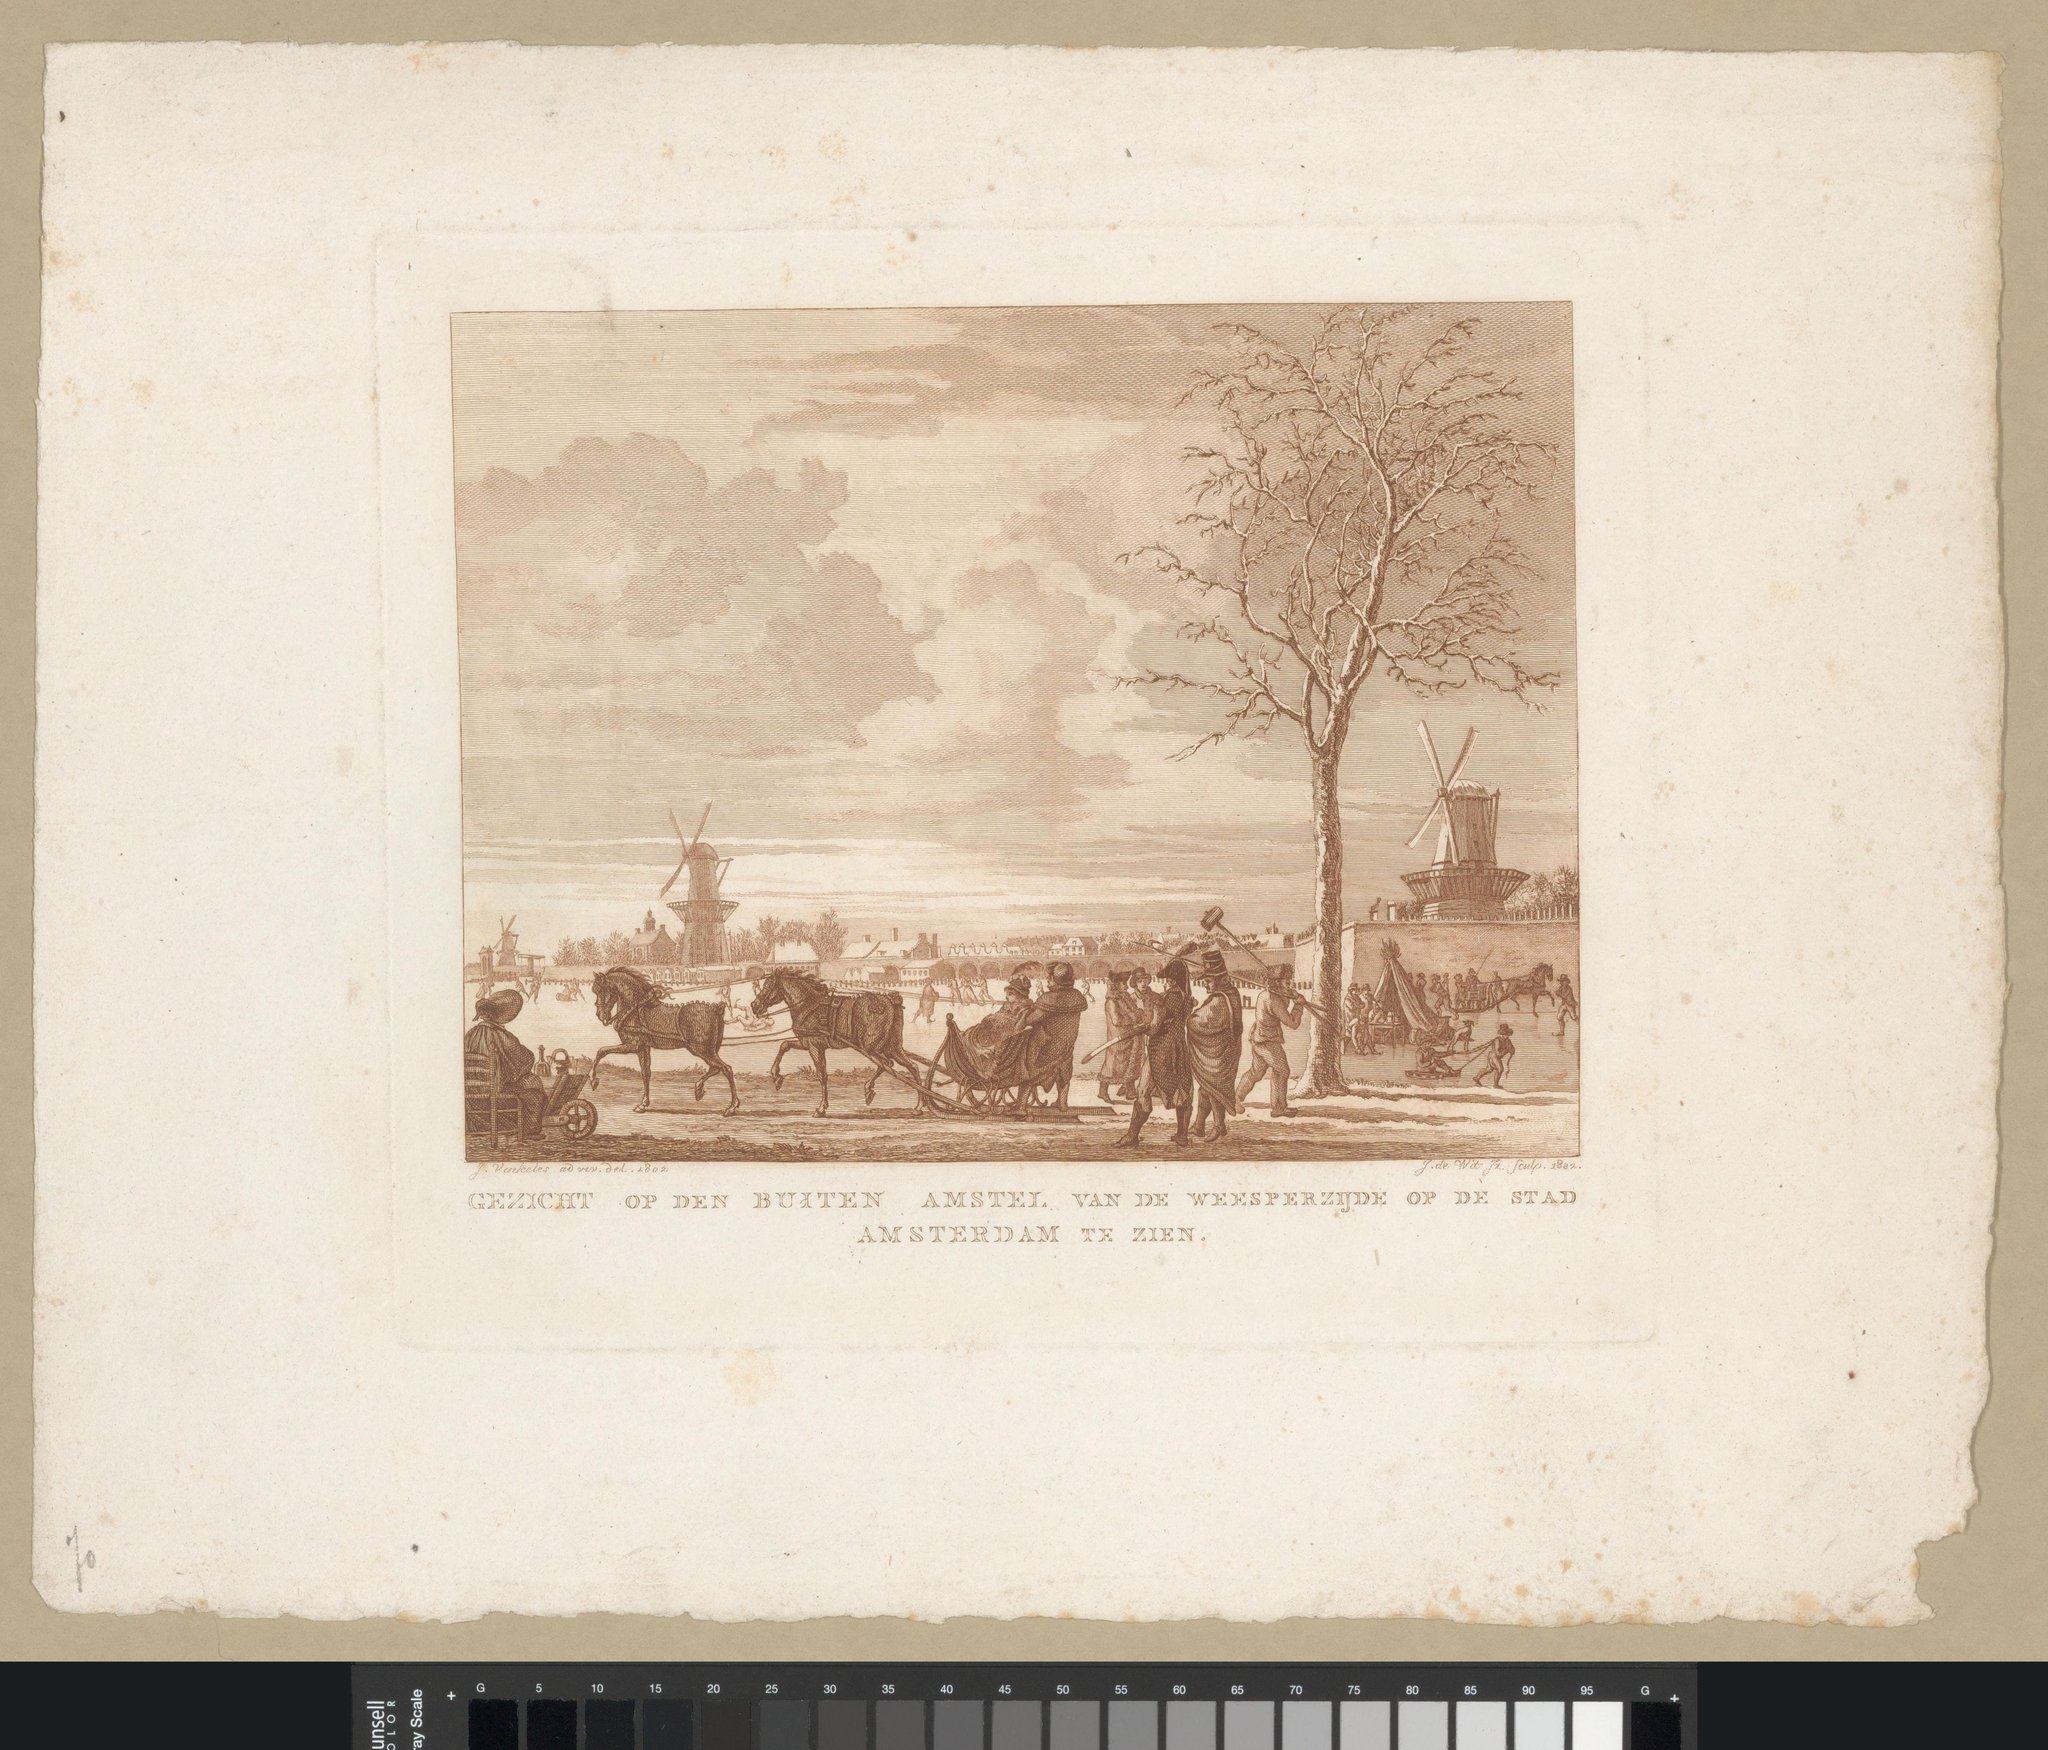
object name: print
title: Wintergezicht op de Amstel bij de Weesperzijde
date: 1802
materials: paper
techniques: etching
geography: haarlem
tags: horse-sleigh, city-view in general; 'veduta', river, winter landscape; landscape symbolizing winter (the four seasons of the year), windmill in landscape, skates (winter sports)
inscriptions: collector's mark: ‘4’ Lugt 1641b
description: Onderwerpsrubriek binnen de Atlas Amsterdam: Amstel van Hogesluis stroomopwaarts.